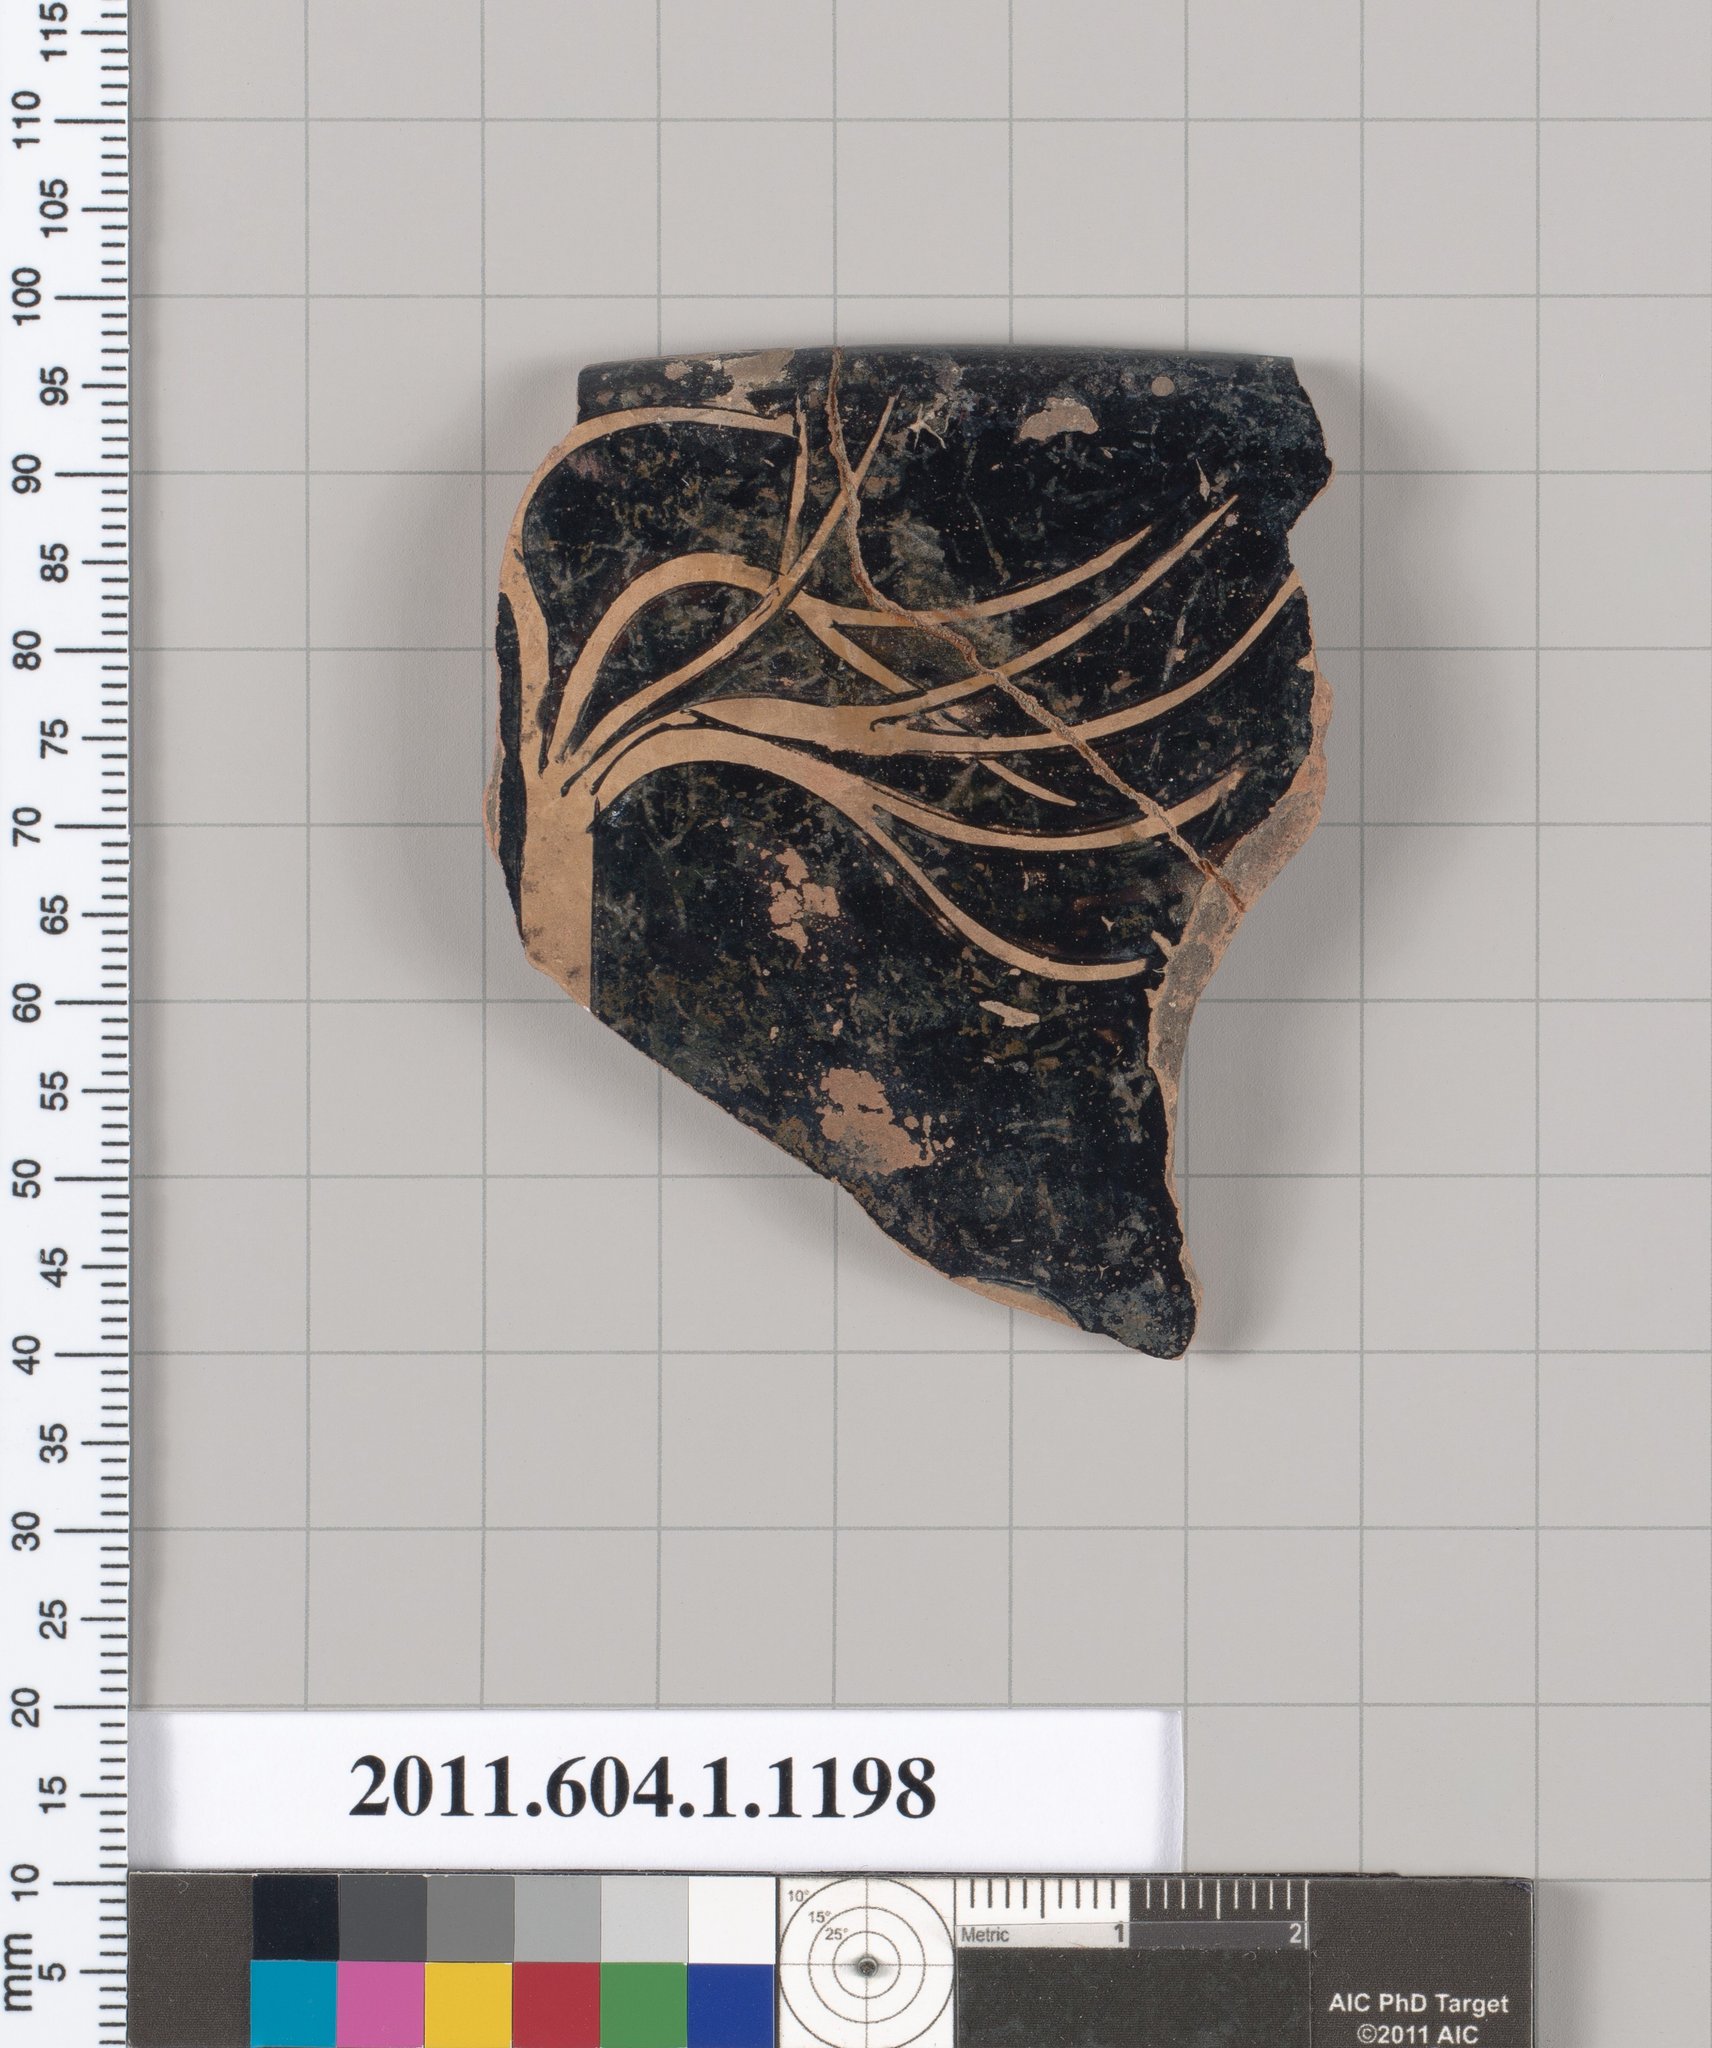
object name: kylix fragment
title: Terracotta rim fragment of a kylix (drinking cup)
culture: greek, attic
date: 500-480 BCE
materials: terracotta